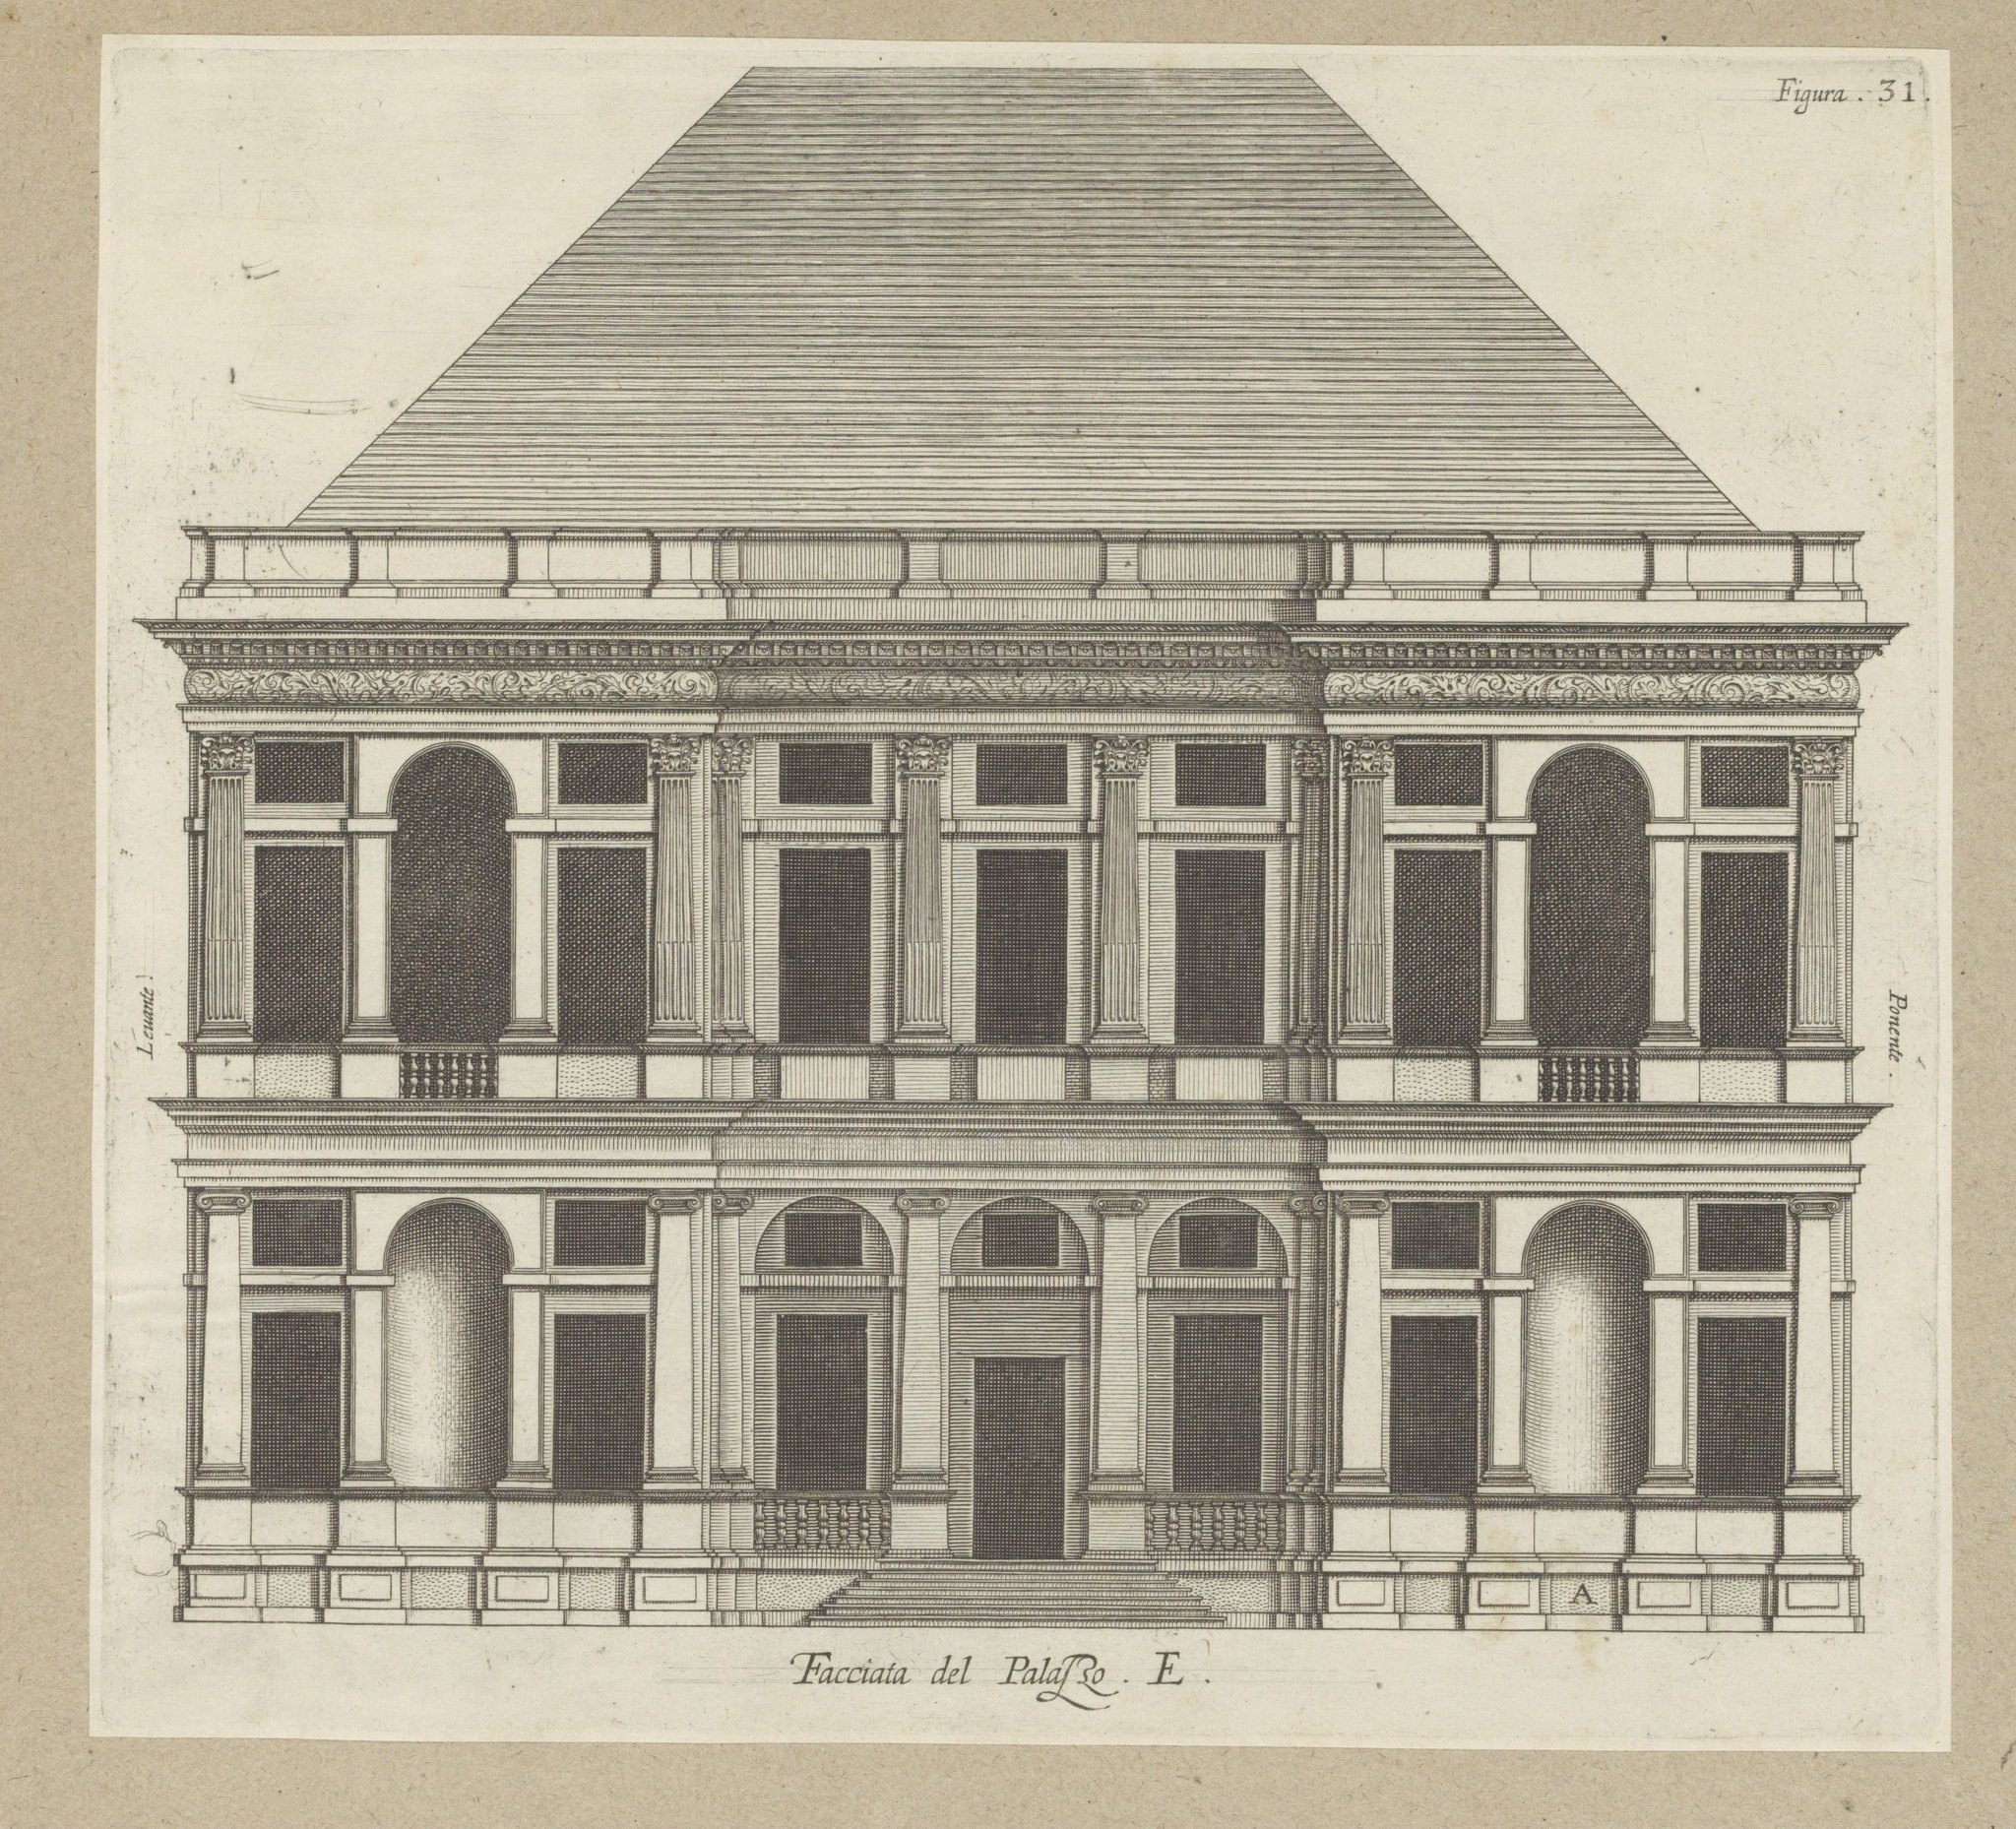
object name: print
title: Opstand van de façade van de villa Pallavicino delle Peschiere te Genua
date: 1622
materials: paper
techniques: engraving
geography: antwerp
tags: hôtel, i.e. small palace in city, exterior ~ architectural design or model, front façade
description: Deze prent maakt deel uit van een album.